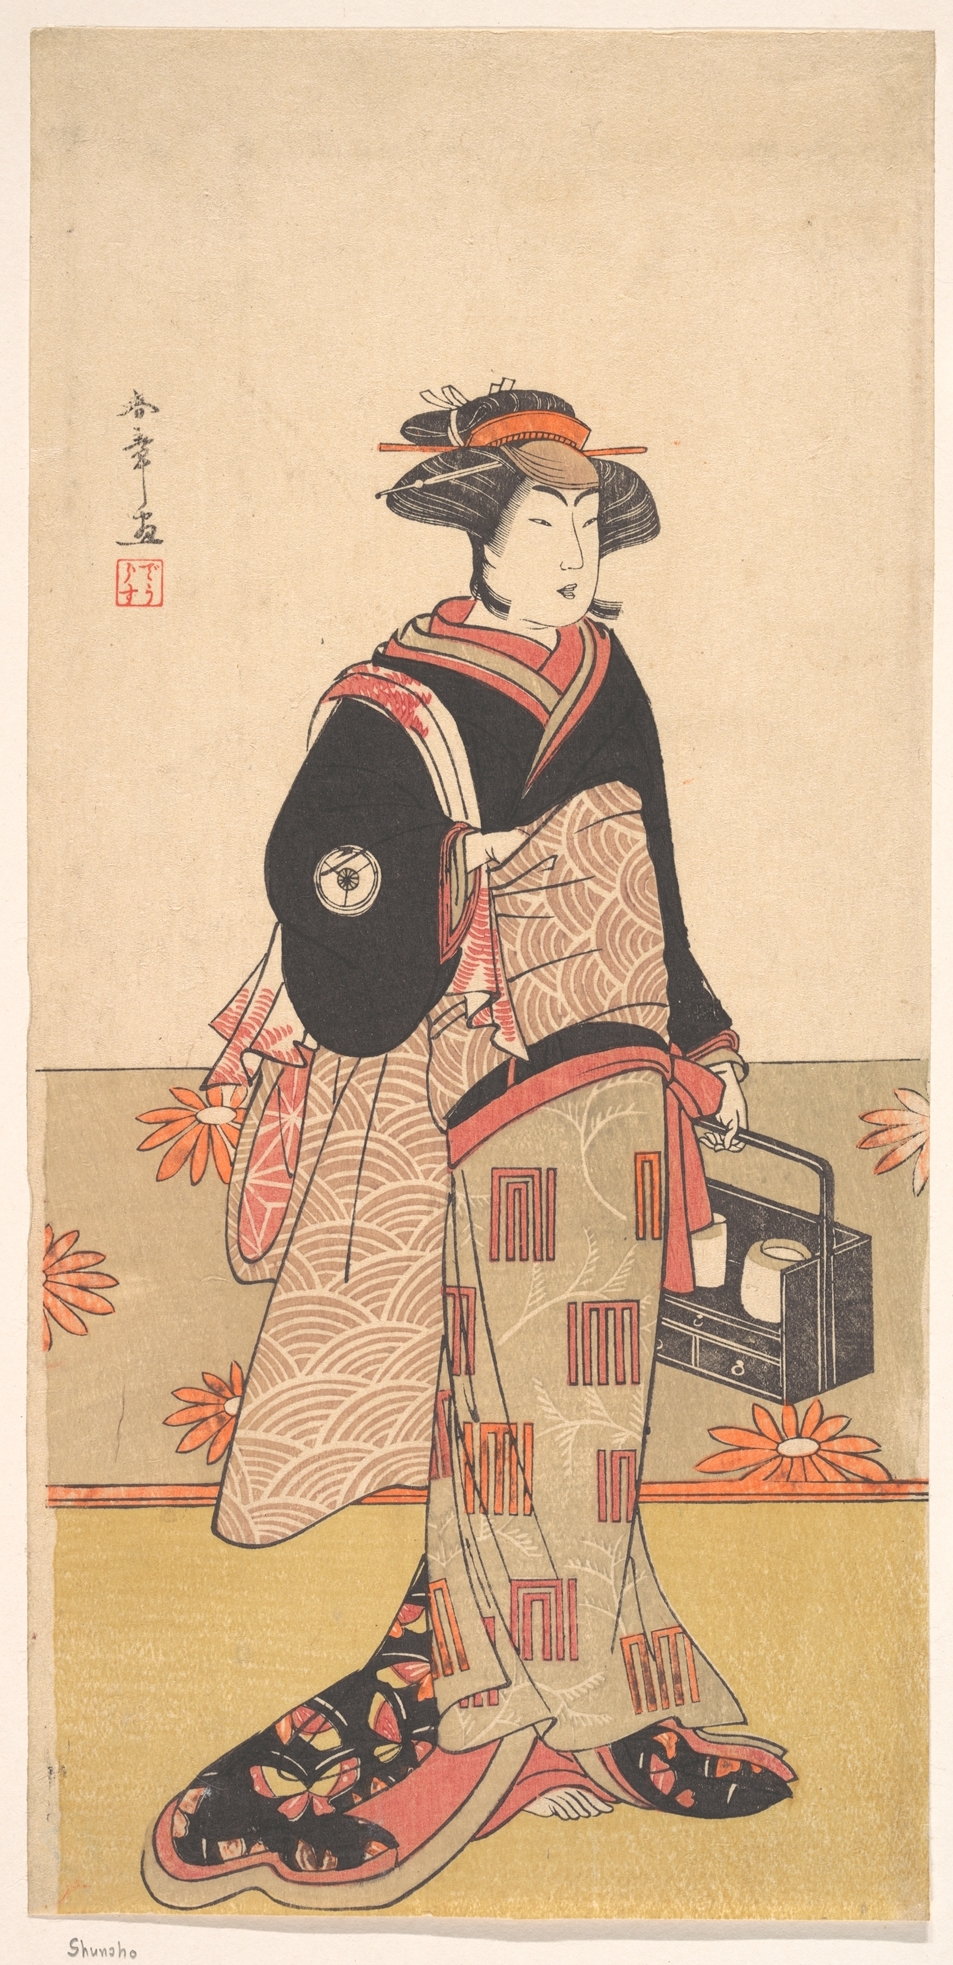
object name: woodblock print nishiki e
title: The Actor Iwai Hanshiro IV as a Woman in a Black Kimono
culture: japanese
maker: katsukawa shunshō 勝川春章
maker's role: artist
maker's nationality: japanese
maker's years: 1726-1792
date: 1780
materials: ink, paper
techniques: nishiki e, woodblock print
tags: women,actors